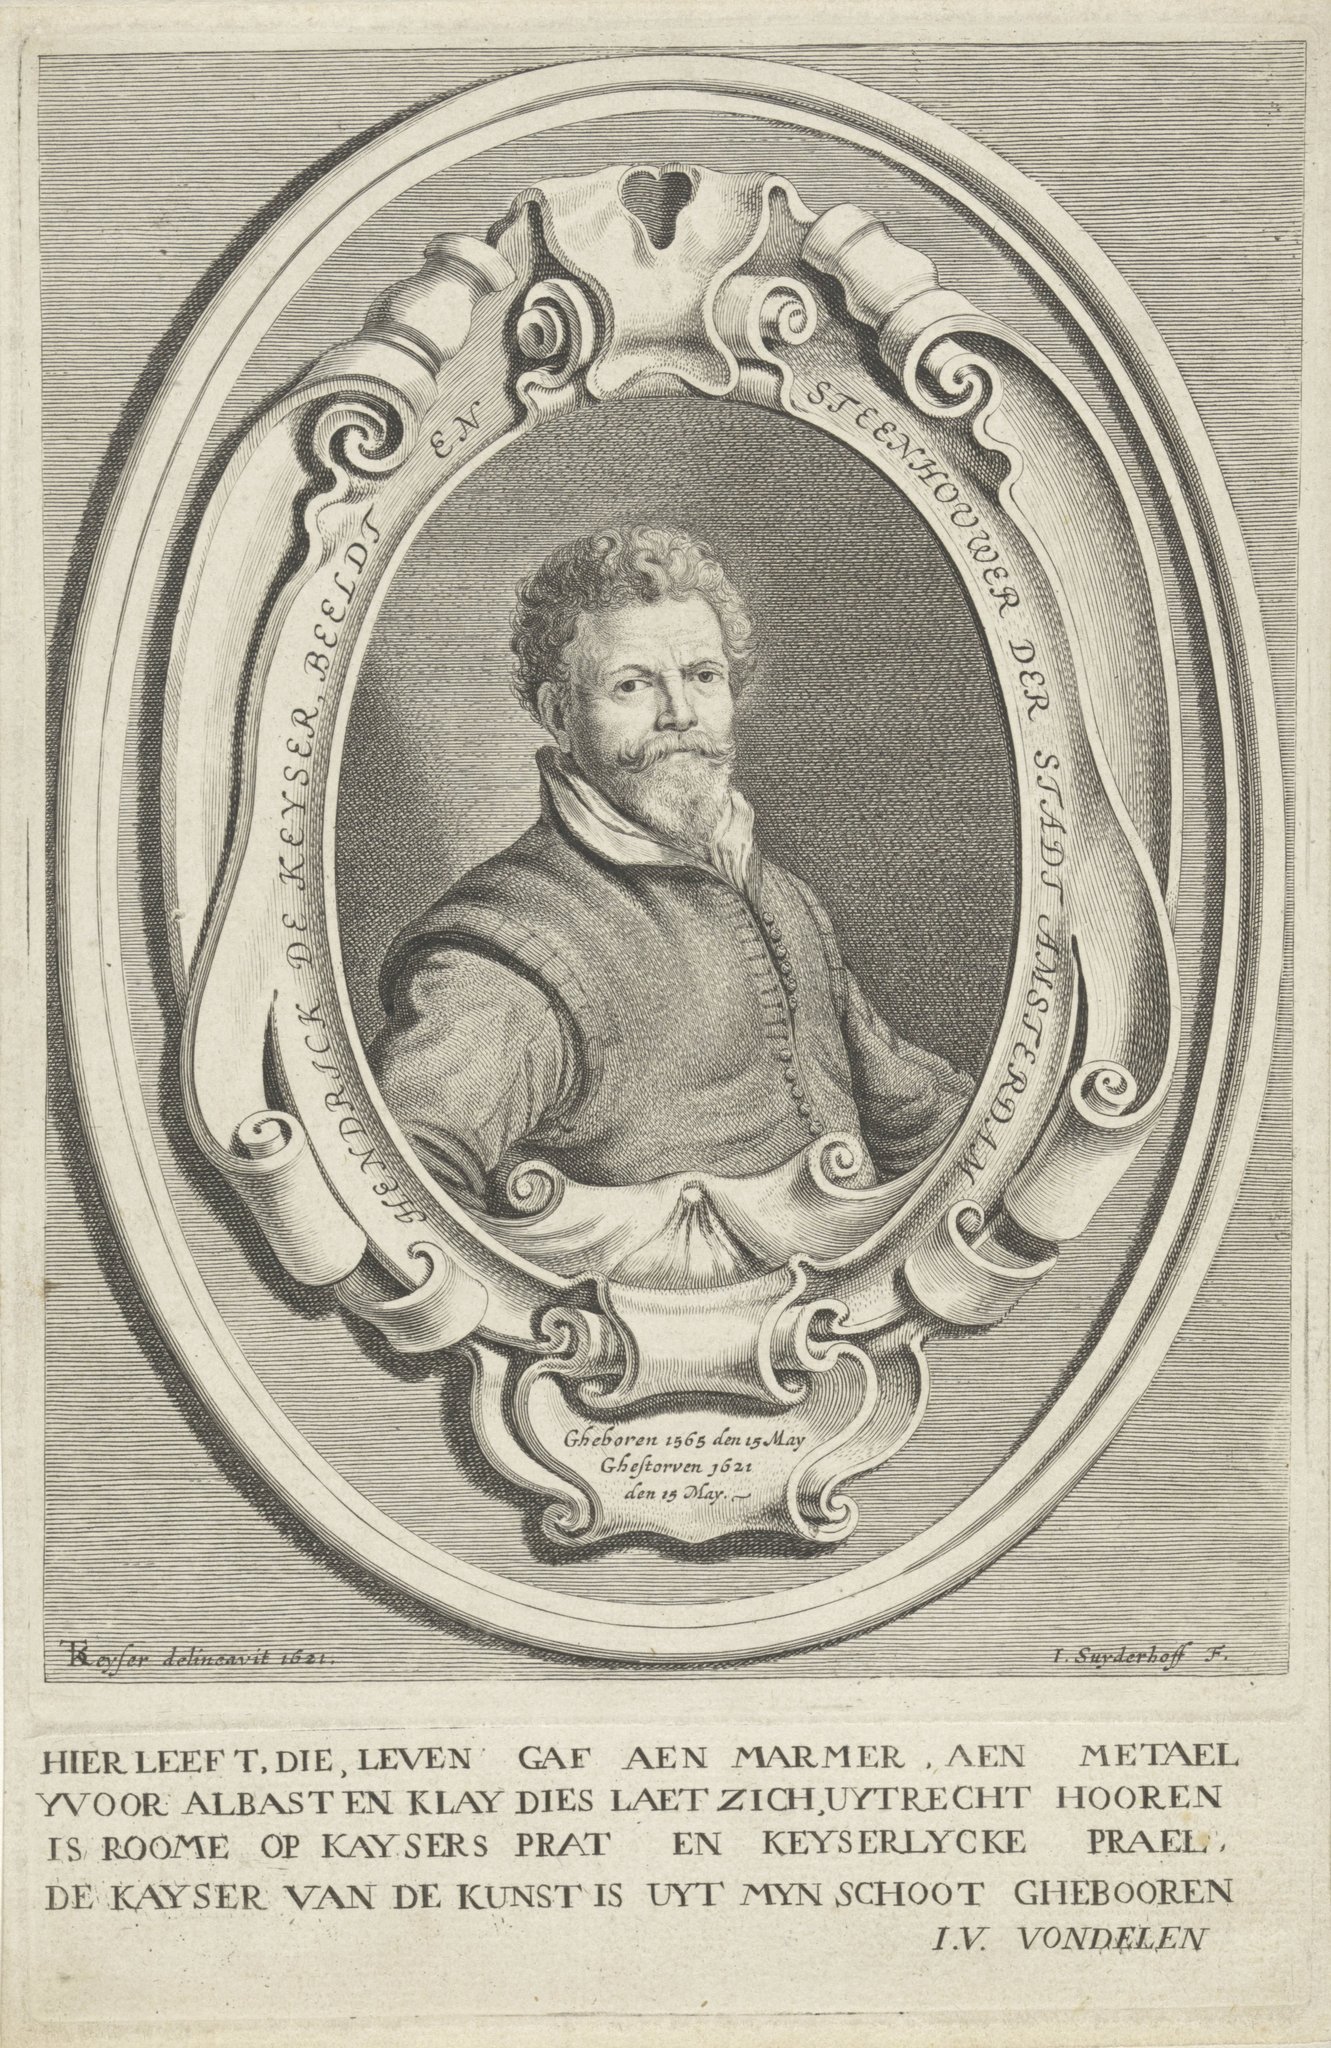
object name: print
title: Portret van Hendrik de Keyser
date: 1623-1686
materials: paper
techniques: engraving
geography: haarlem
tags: amsterdam, print maker, hendrick de keyser (i), portrait, self-portrait of sculptor, portrait, self-portrait of architect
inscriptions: collector's mark: Lugt 2228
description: Portret van Hendrik de Keyser, architect en beeldhouwer te Amsterdam, in een ovale lijst met rolwerk.